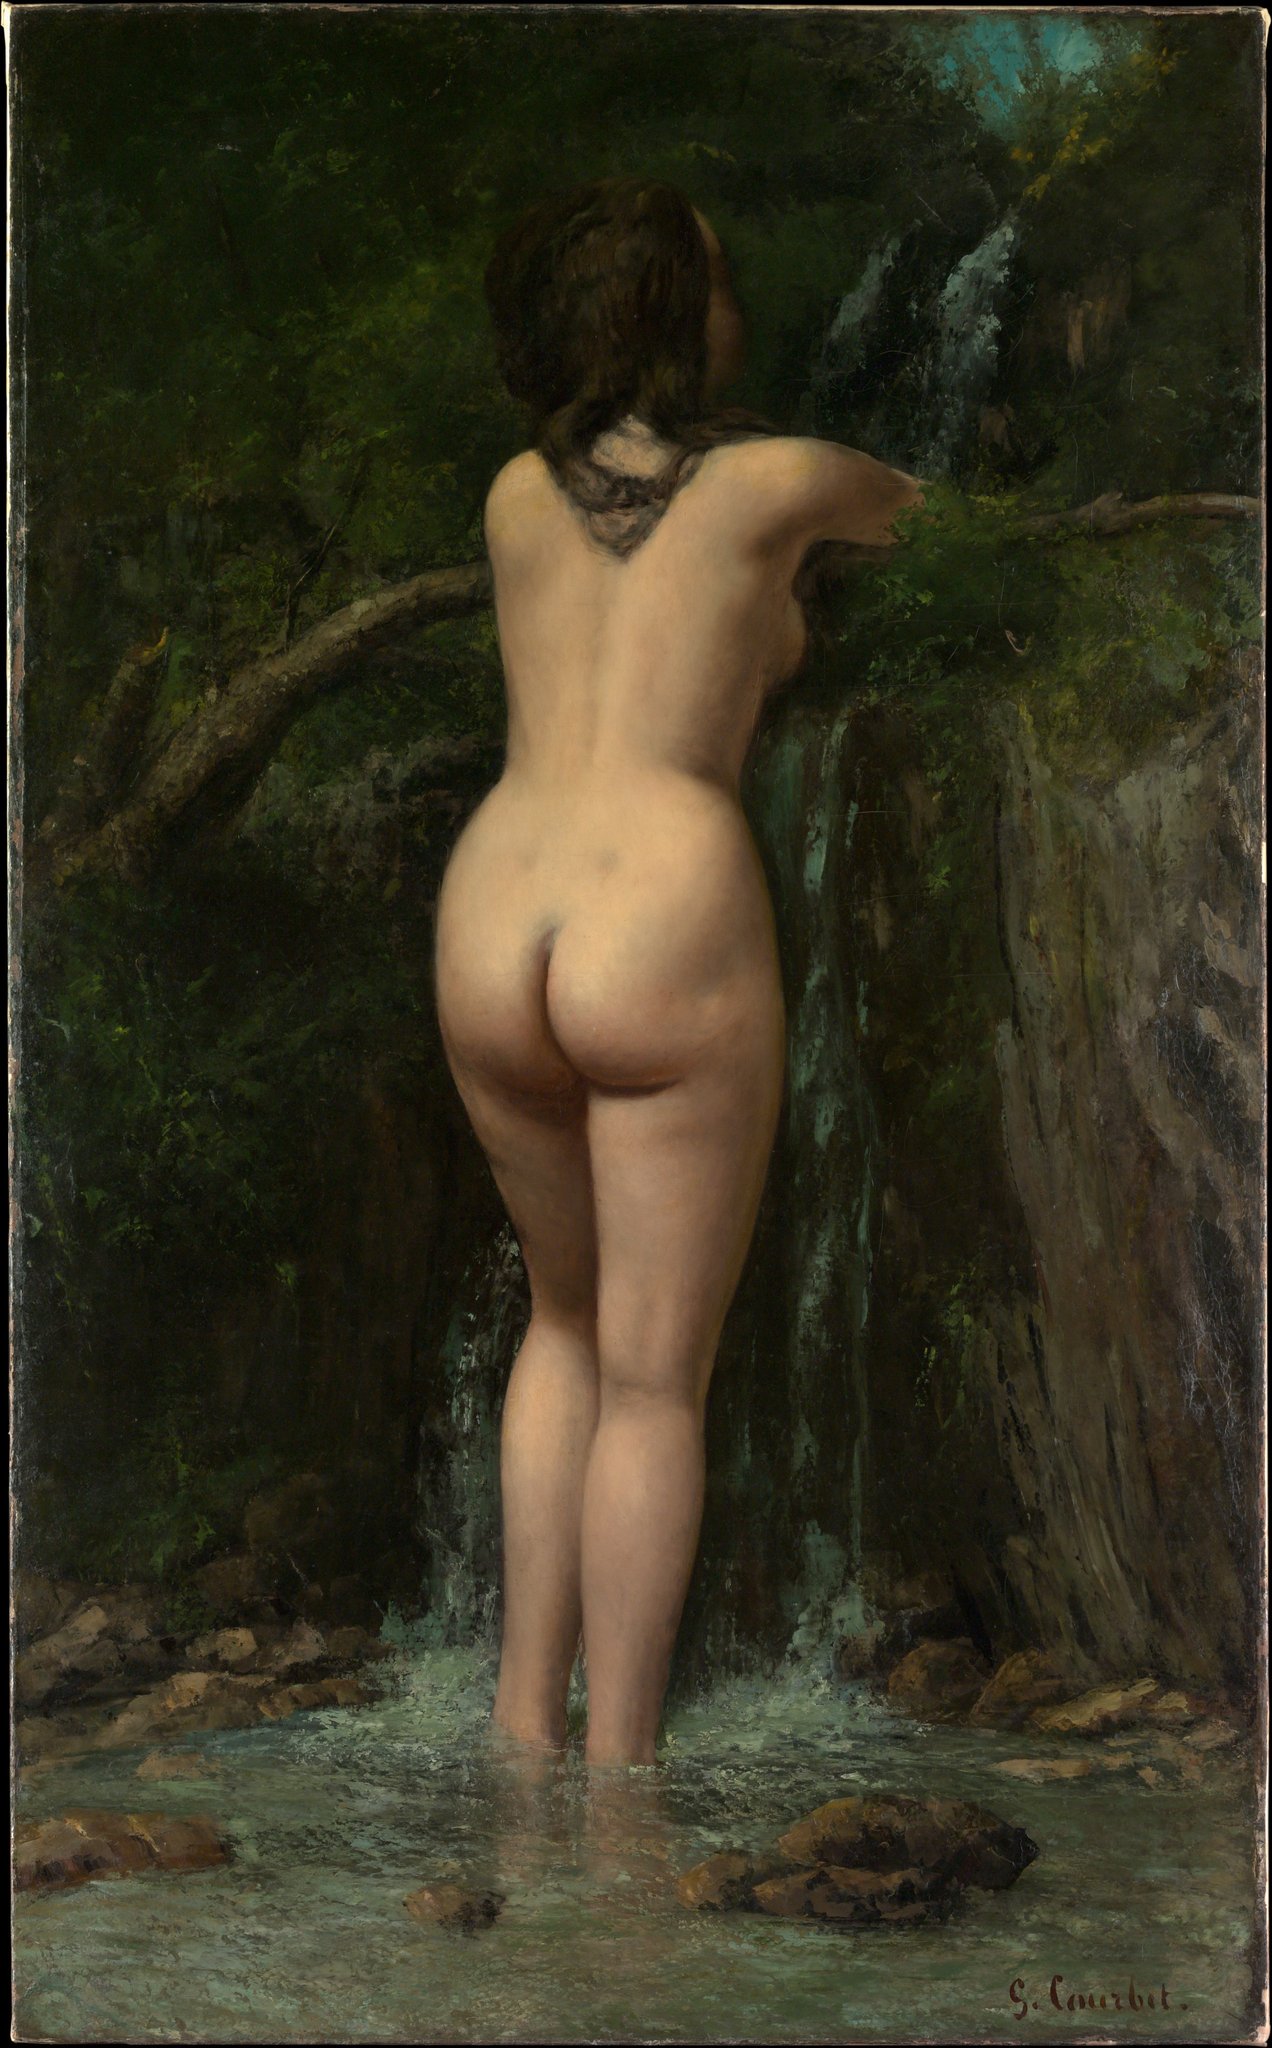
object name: painting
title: The Source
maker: gustave courbet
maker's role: artist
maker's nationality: french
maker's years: 1819-1877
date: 1862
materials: canvas, oil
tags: female nudes